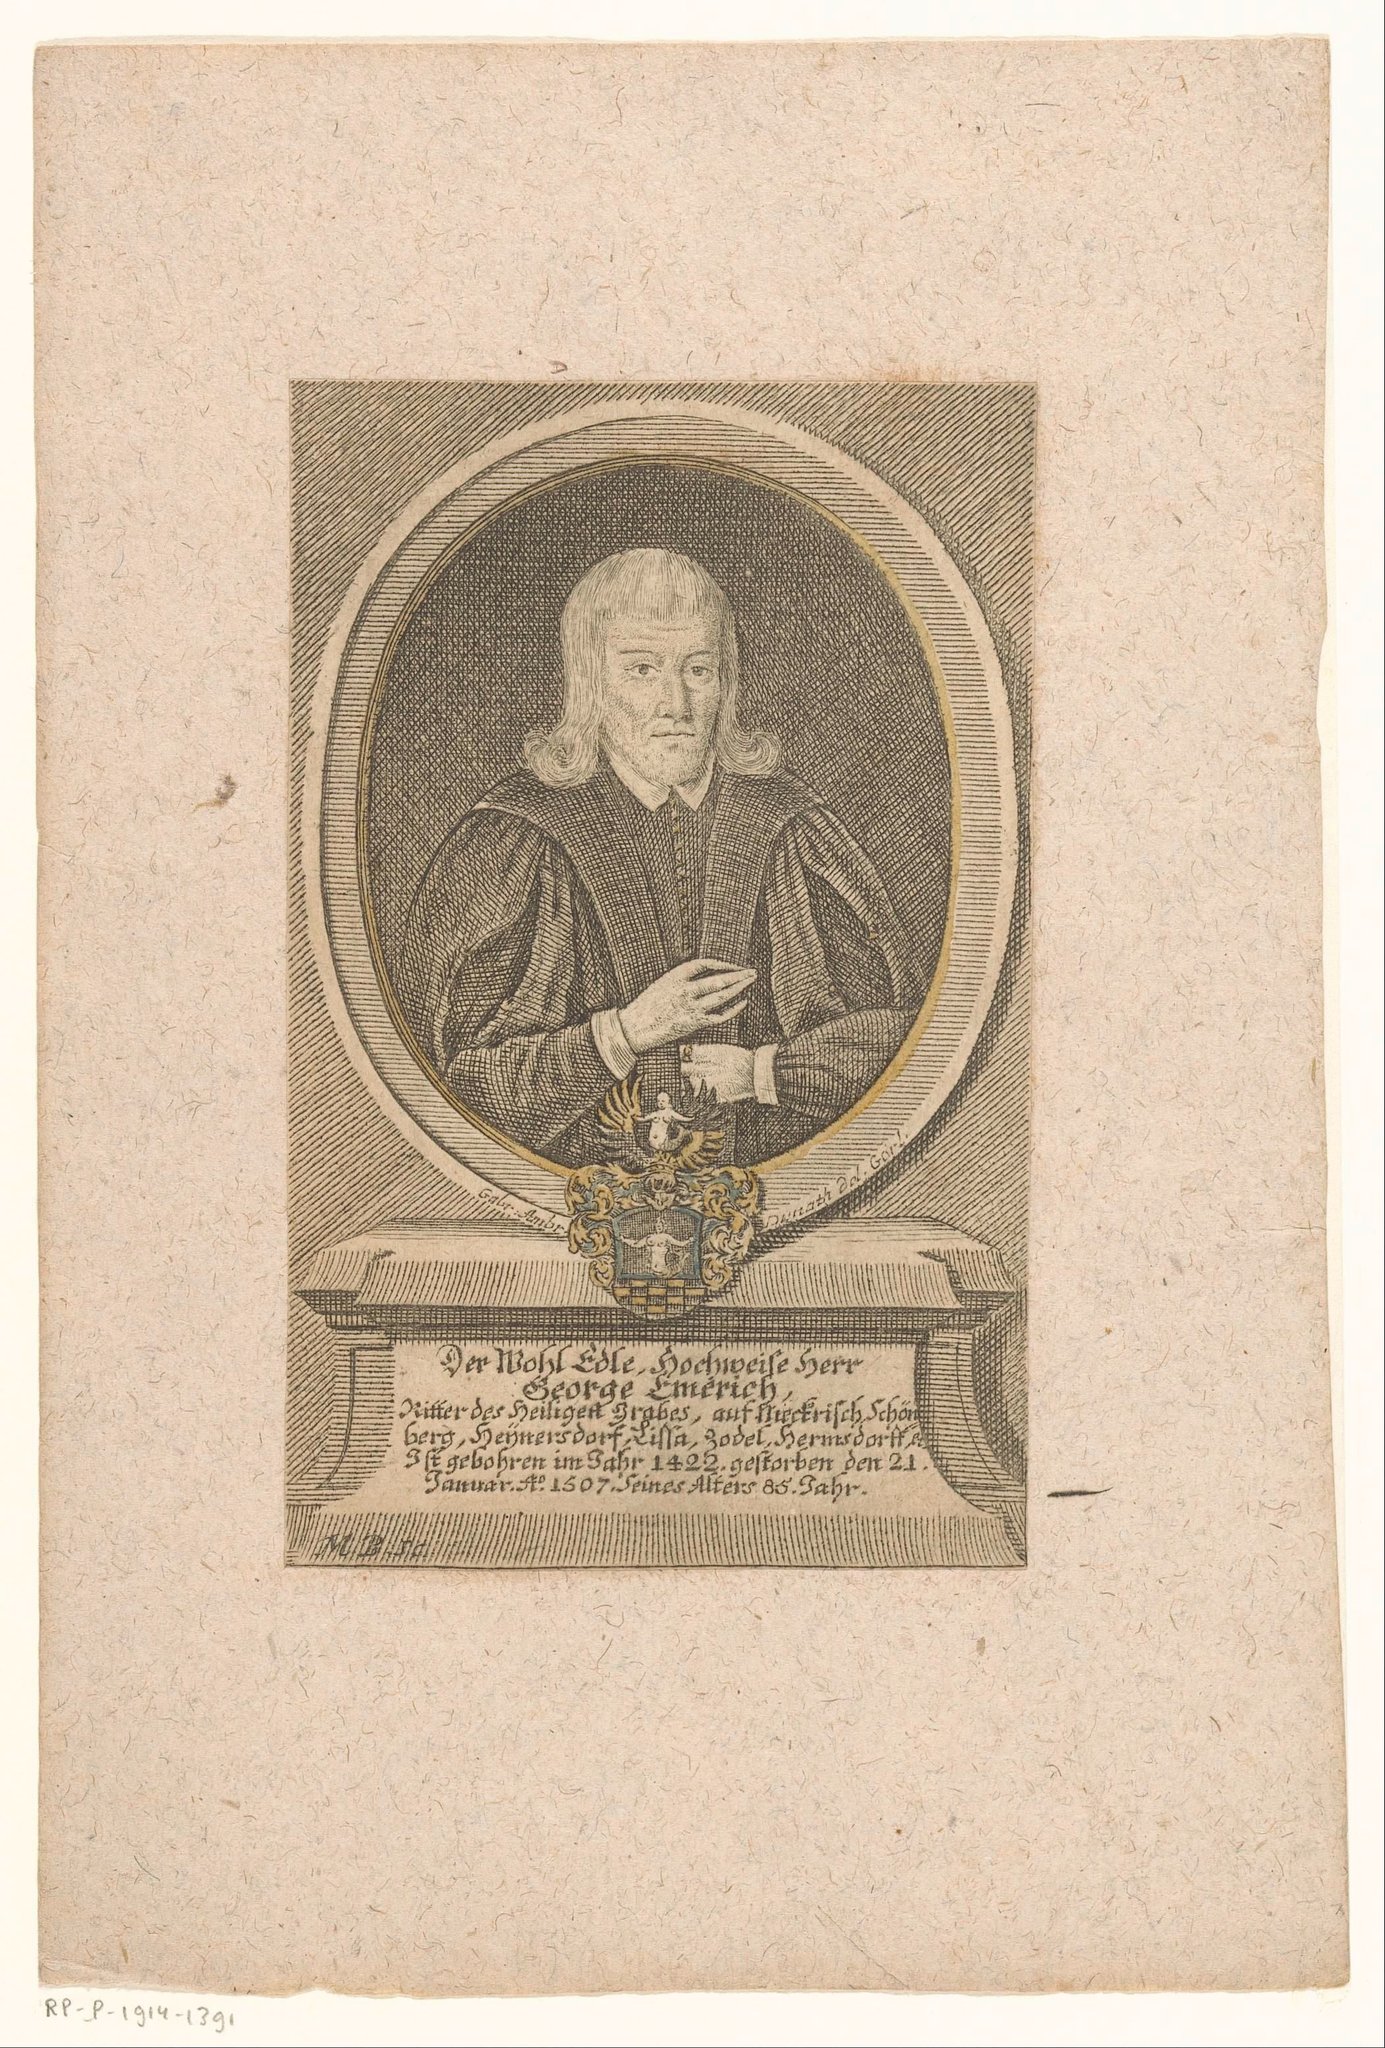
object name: print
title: Portret van Georg Emerich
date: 1675-1748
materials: paper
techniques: engraving, hand coloring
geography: görlitz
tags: mayor, historical persons, armorial bearing, heraldry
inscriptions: collector's mark: Lugt 2228